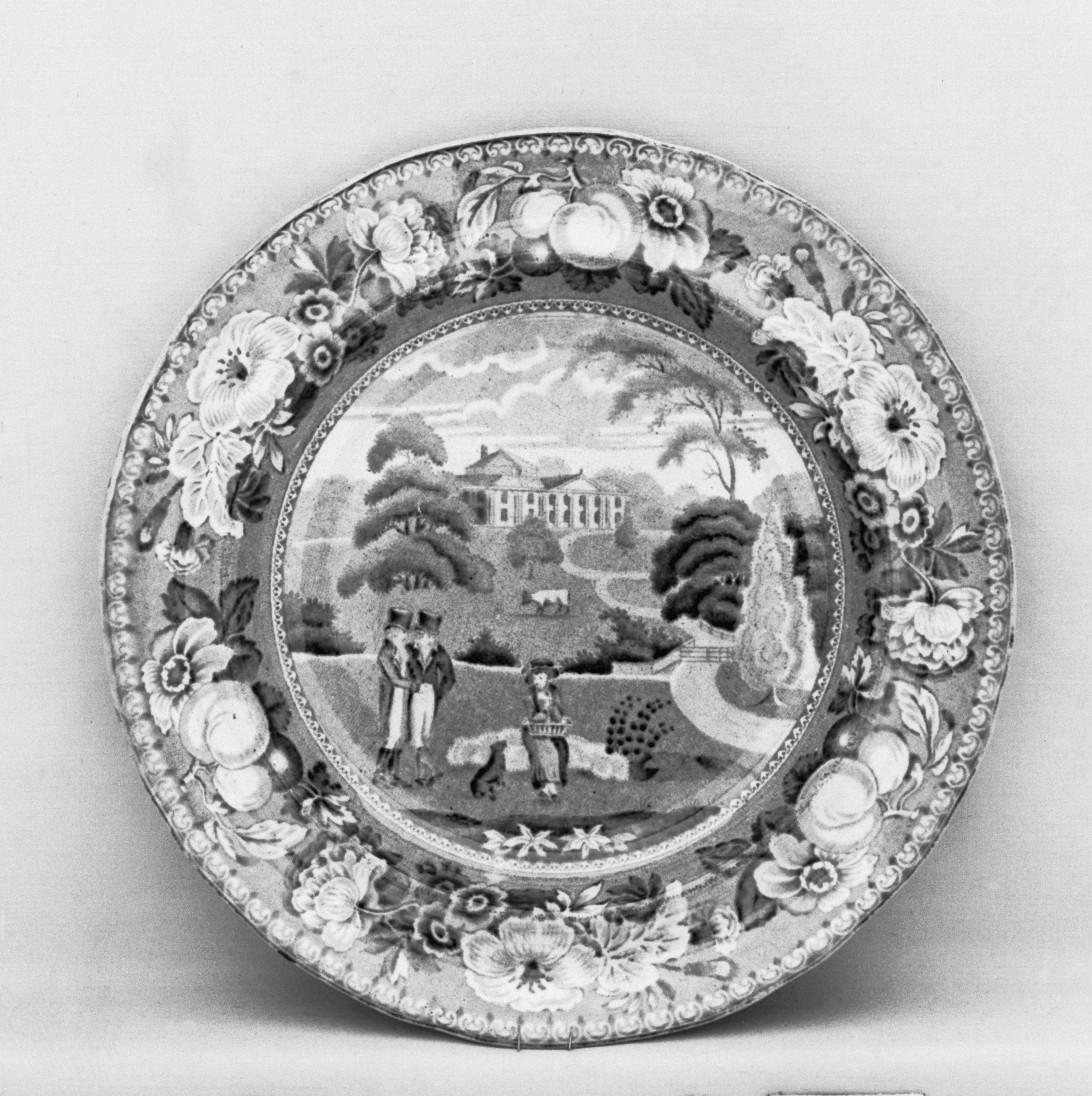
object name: plate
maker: enoch wood & sons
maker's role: maker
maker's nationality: british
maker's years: 1818-1846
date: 1801-1900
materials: pottery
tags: animals,buildings,flowers,trees